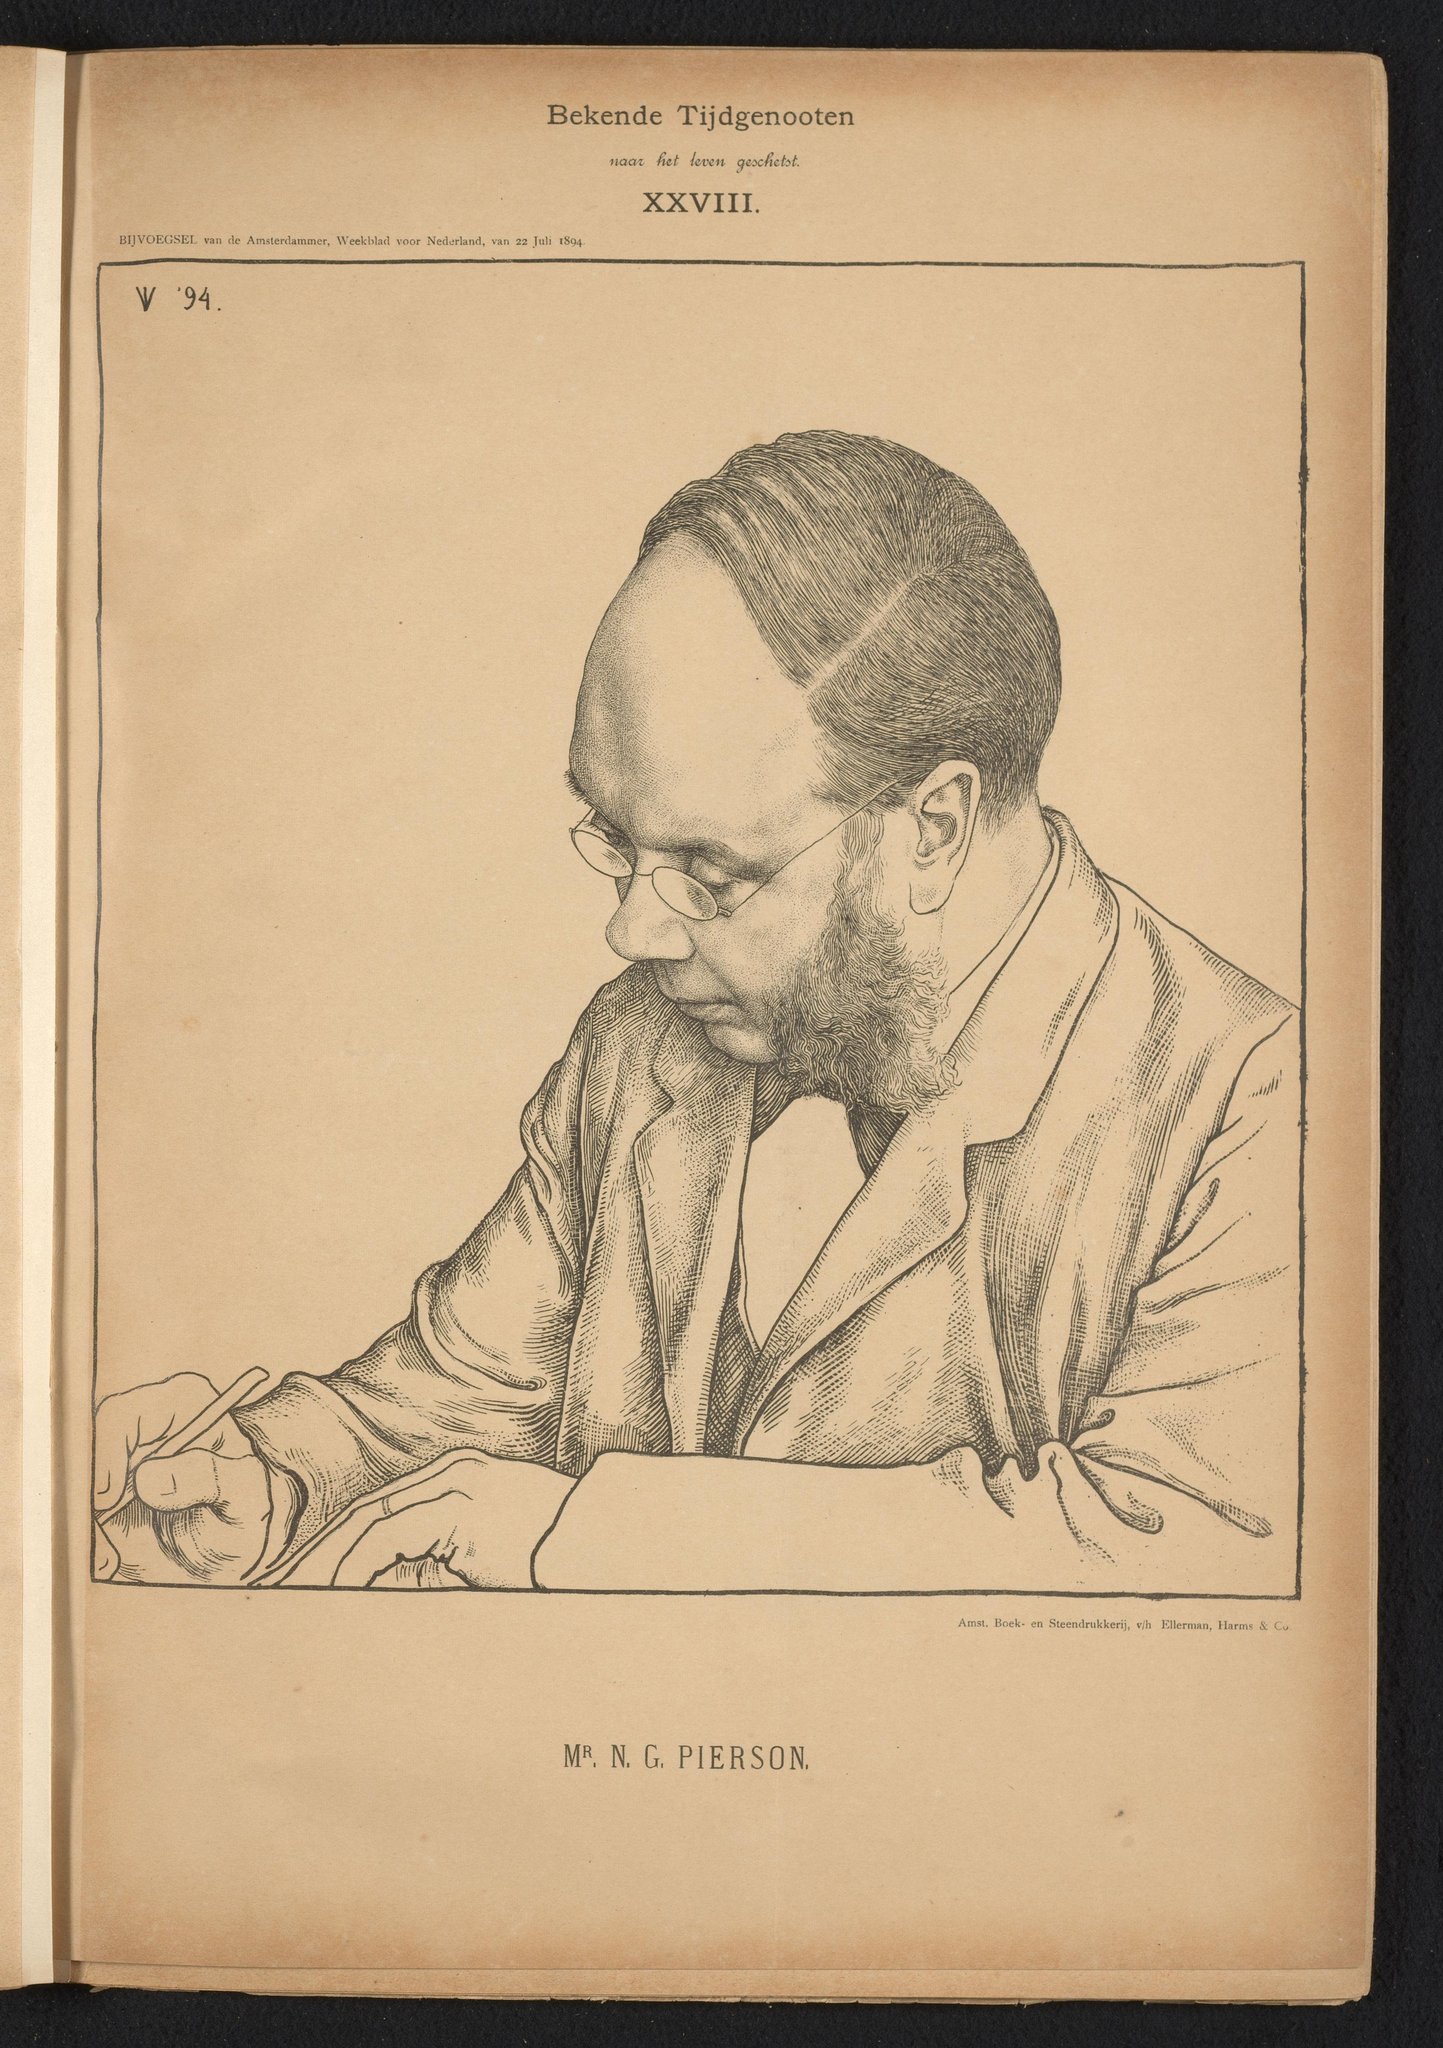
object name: print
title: Bekende Tijdgenooten naar het leven geschetst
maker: jan veth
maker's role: designer, draughtsman, painter, print maker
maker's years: 1864-1925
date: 1894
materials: paper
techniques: lithograph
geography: amsterdam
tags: amsterdam, politician, nicolaas gerard pierson, historical persons (+ (full) bust portrait)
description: Portret van minister Nicolaas Gerard Pierson. In de serie 'Bekende Tijdgenooten', nr. XXVIII.